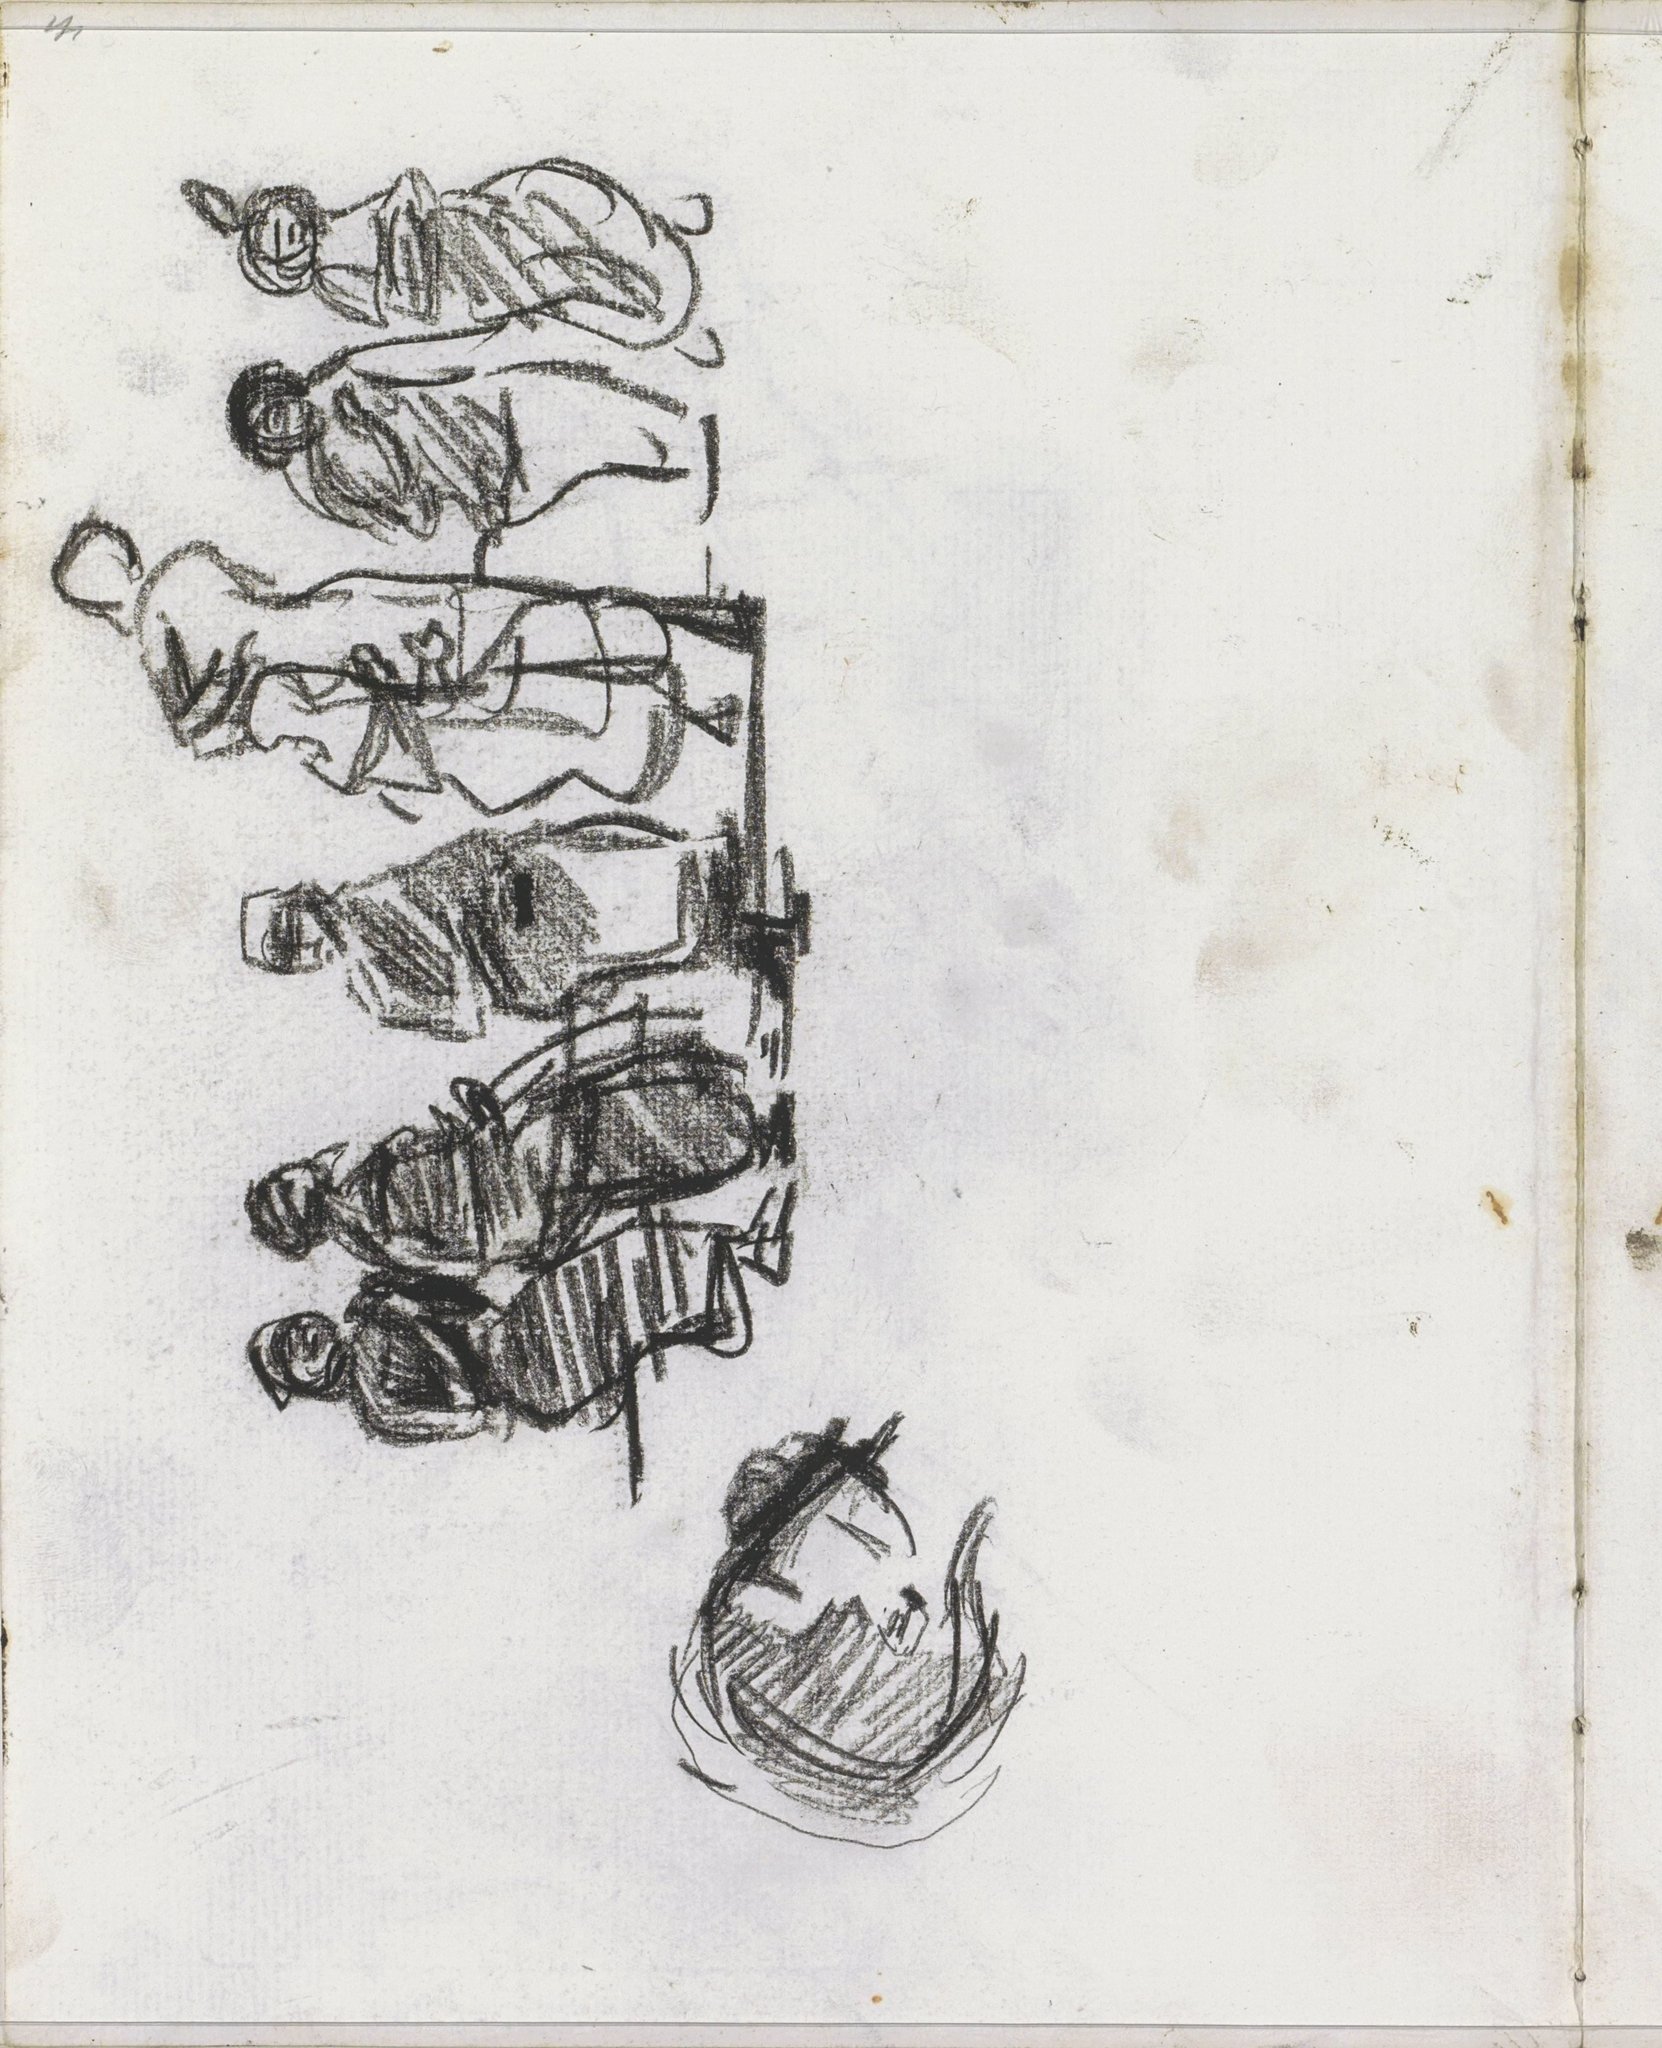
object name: sketchbook leaf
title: Figuurstudies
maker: isaac israels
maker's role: draughtsman, painter, print maker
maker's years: 1865-1934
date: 1875-1934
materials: chalk, paper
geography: the hague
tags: sitting figure, sitting figure - aa - female human figure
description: Zittende en staande figuren, mogelijk vrouwen. Blad 10 verso uit schetsboek XIII met 25 bladen.